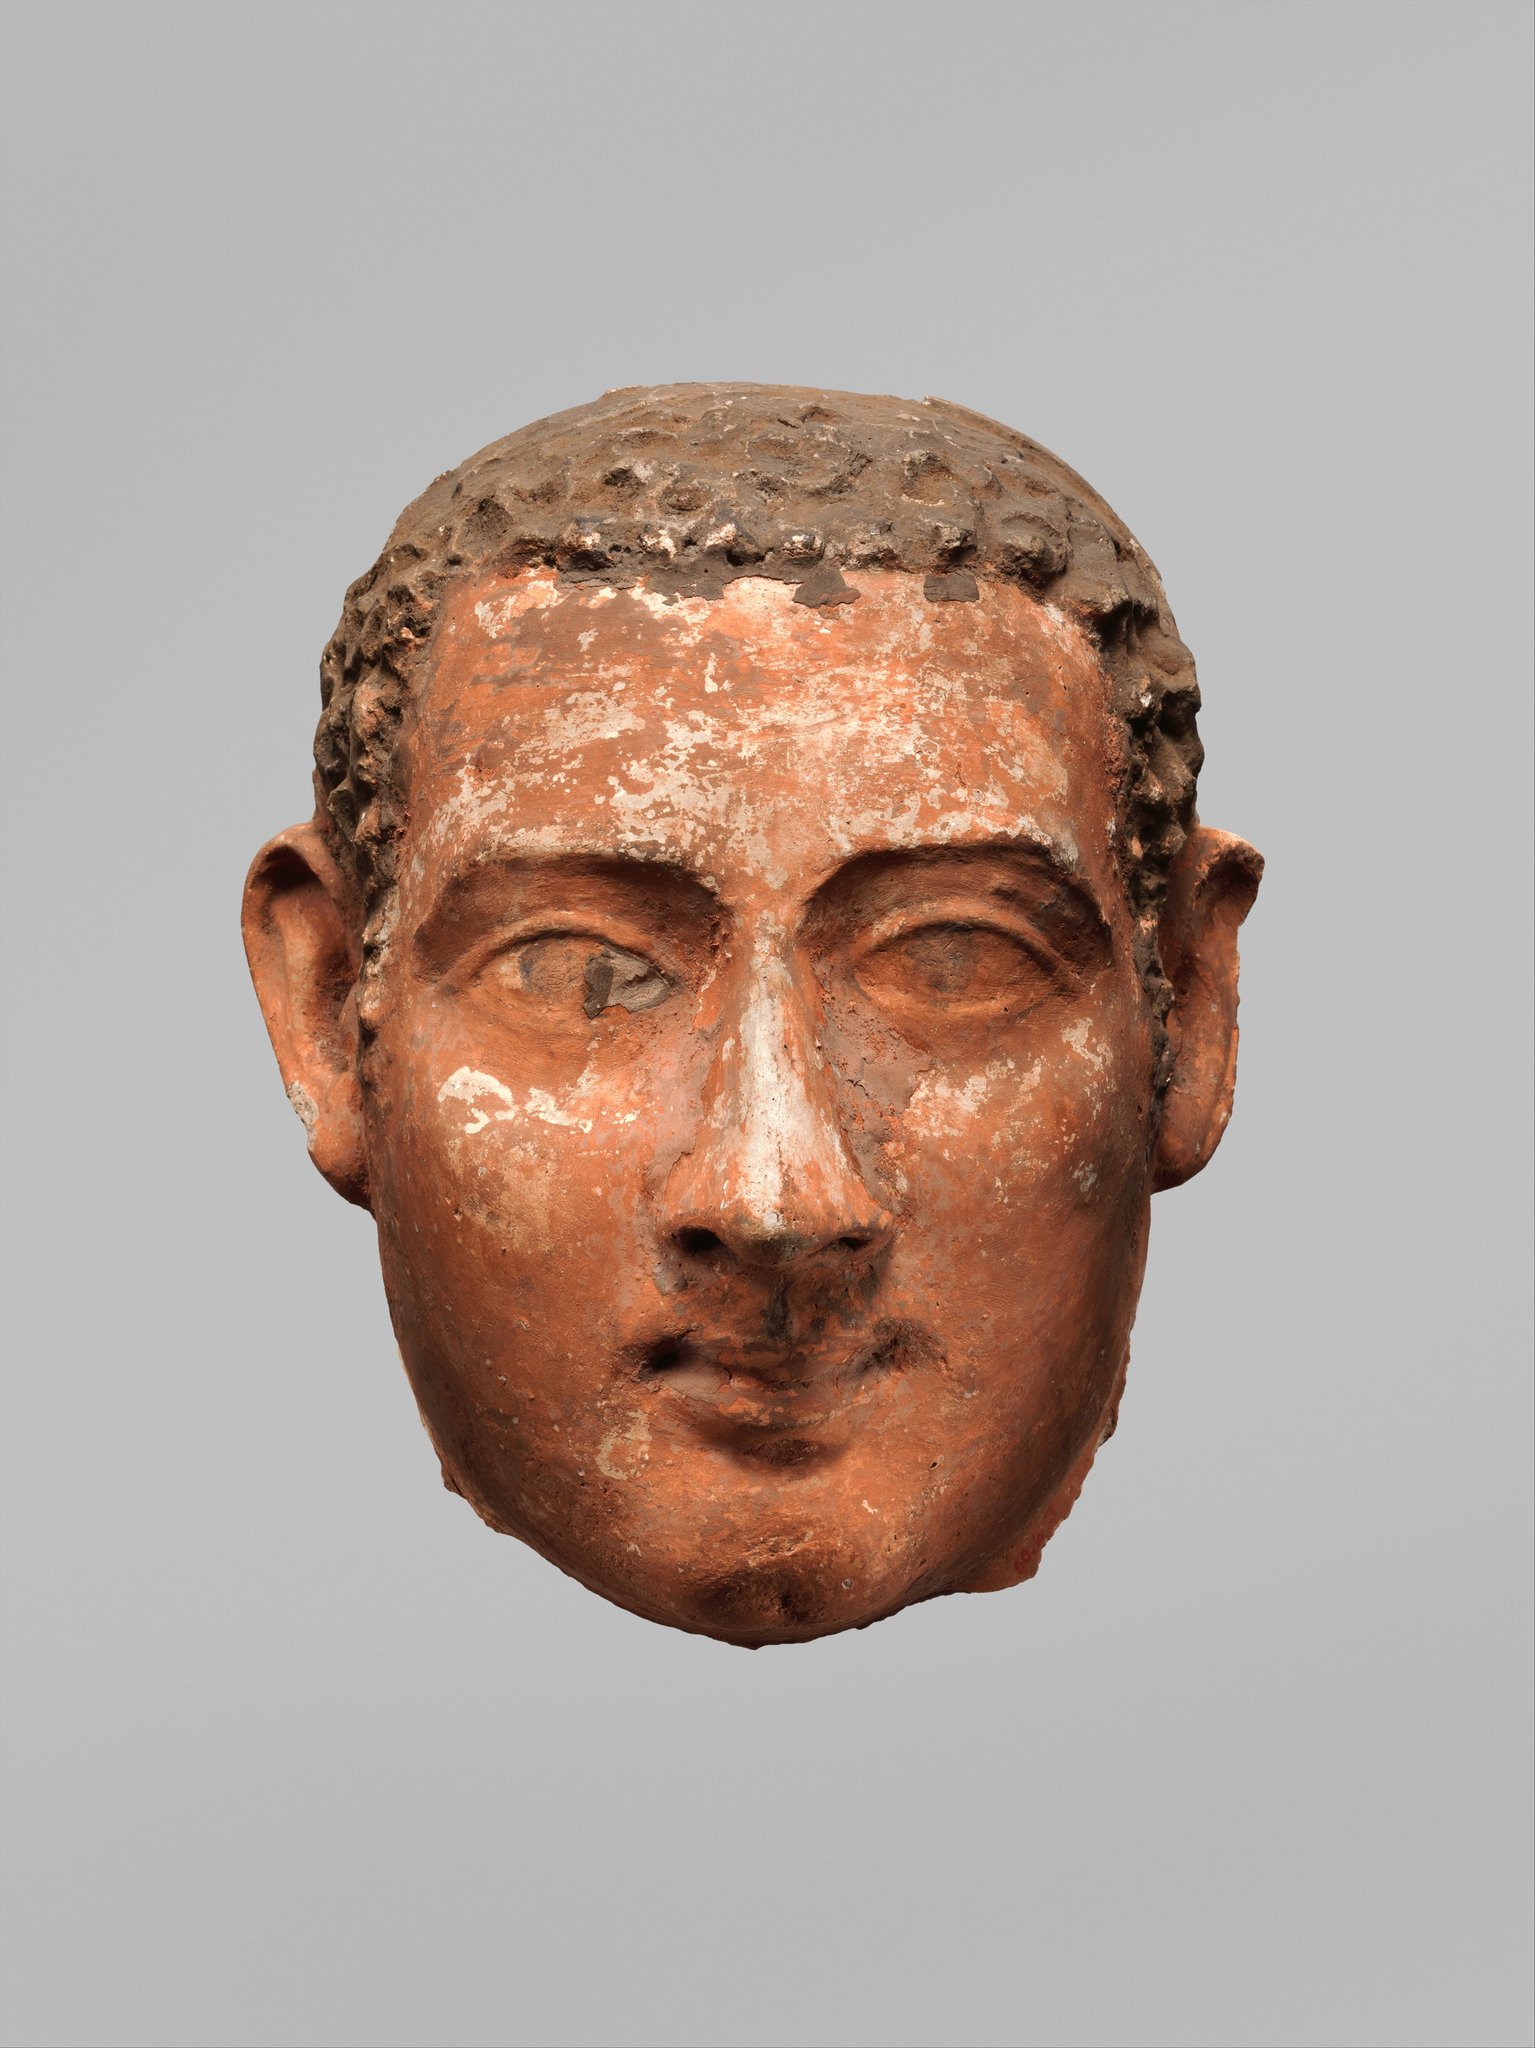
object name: mask, man, short curly hair, long sideburn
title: Mask of a man with short curly hair and long sideburns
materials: paint, plaster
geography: egypt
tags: masks,men